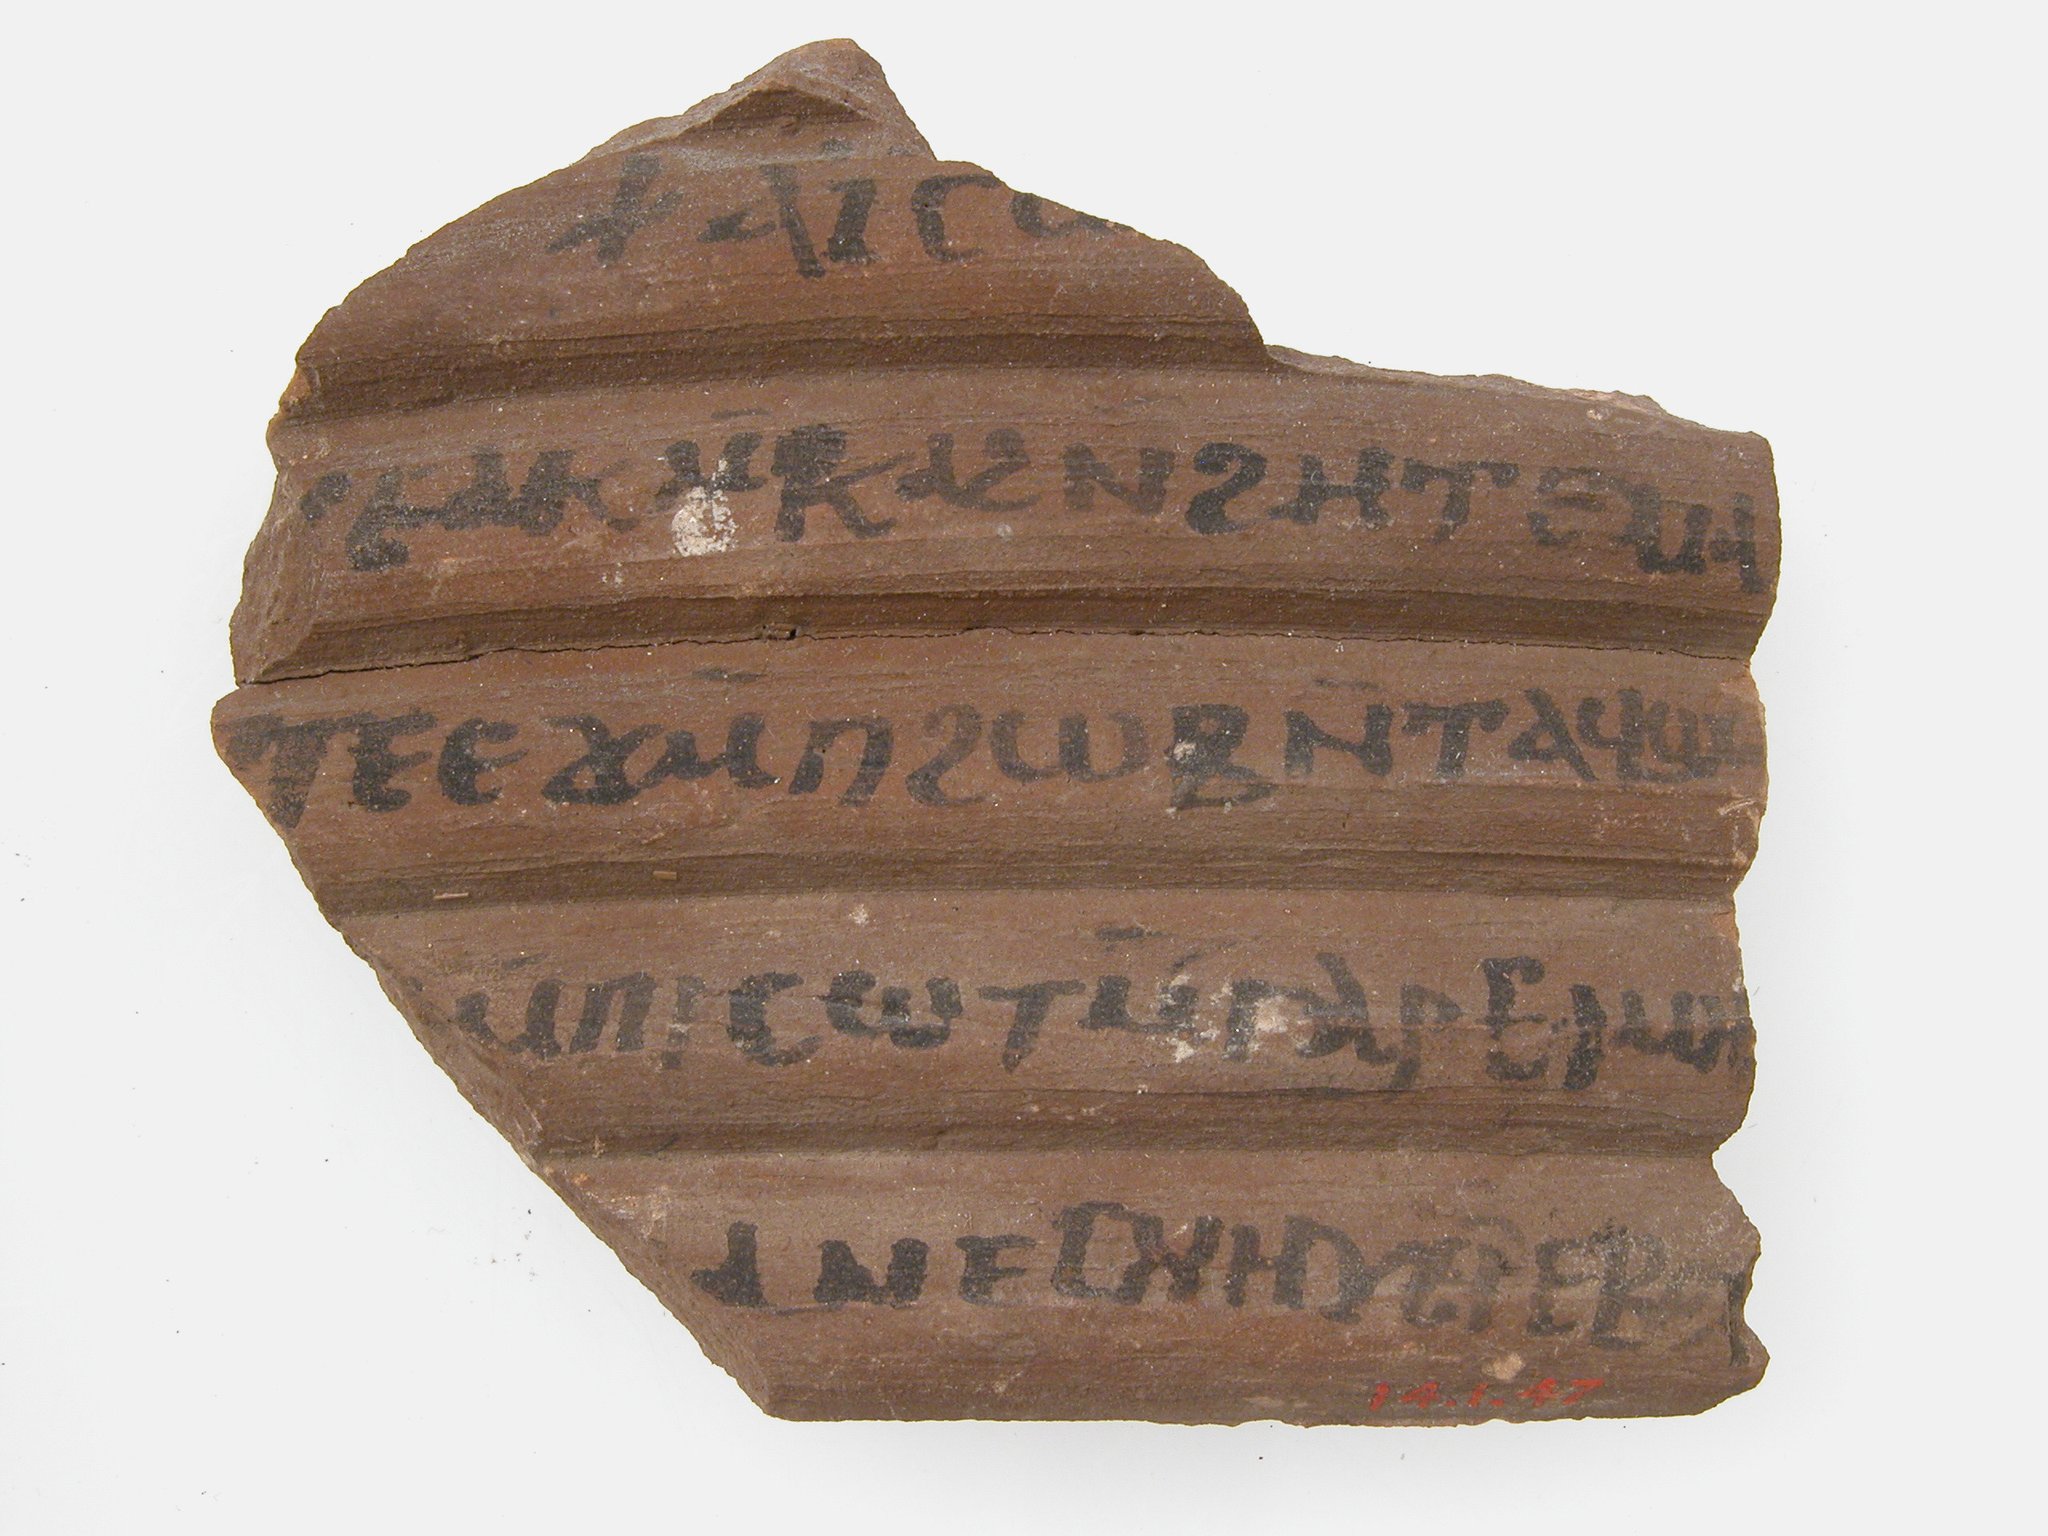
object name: ostrakon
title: Ostrakon with a Letter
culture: coptic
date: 600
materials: ink, pottery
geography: egypt